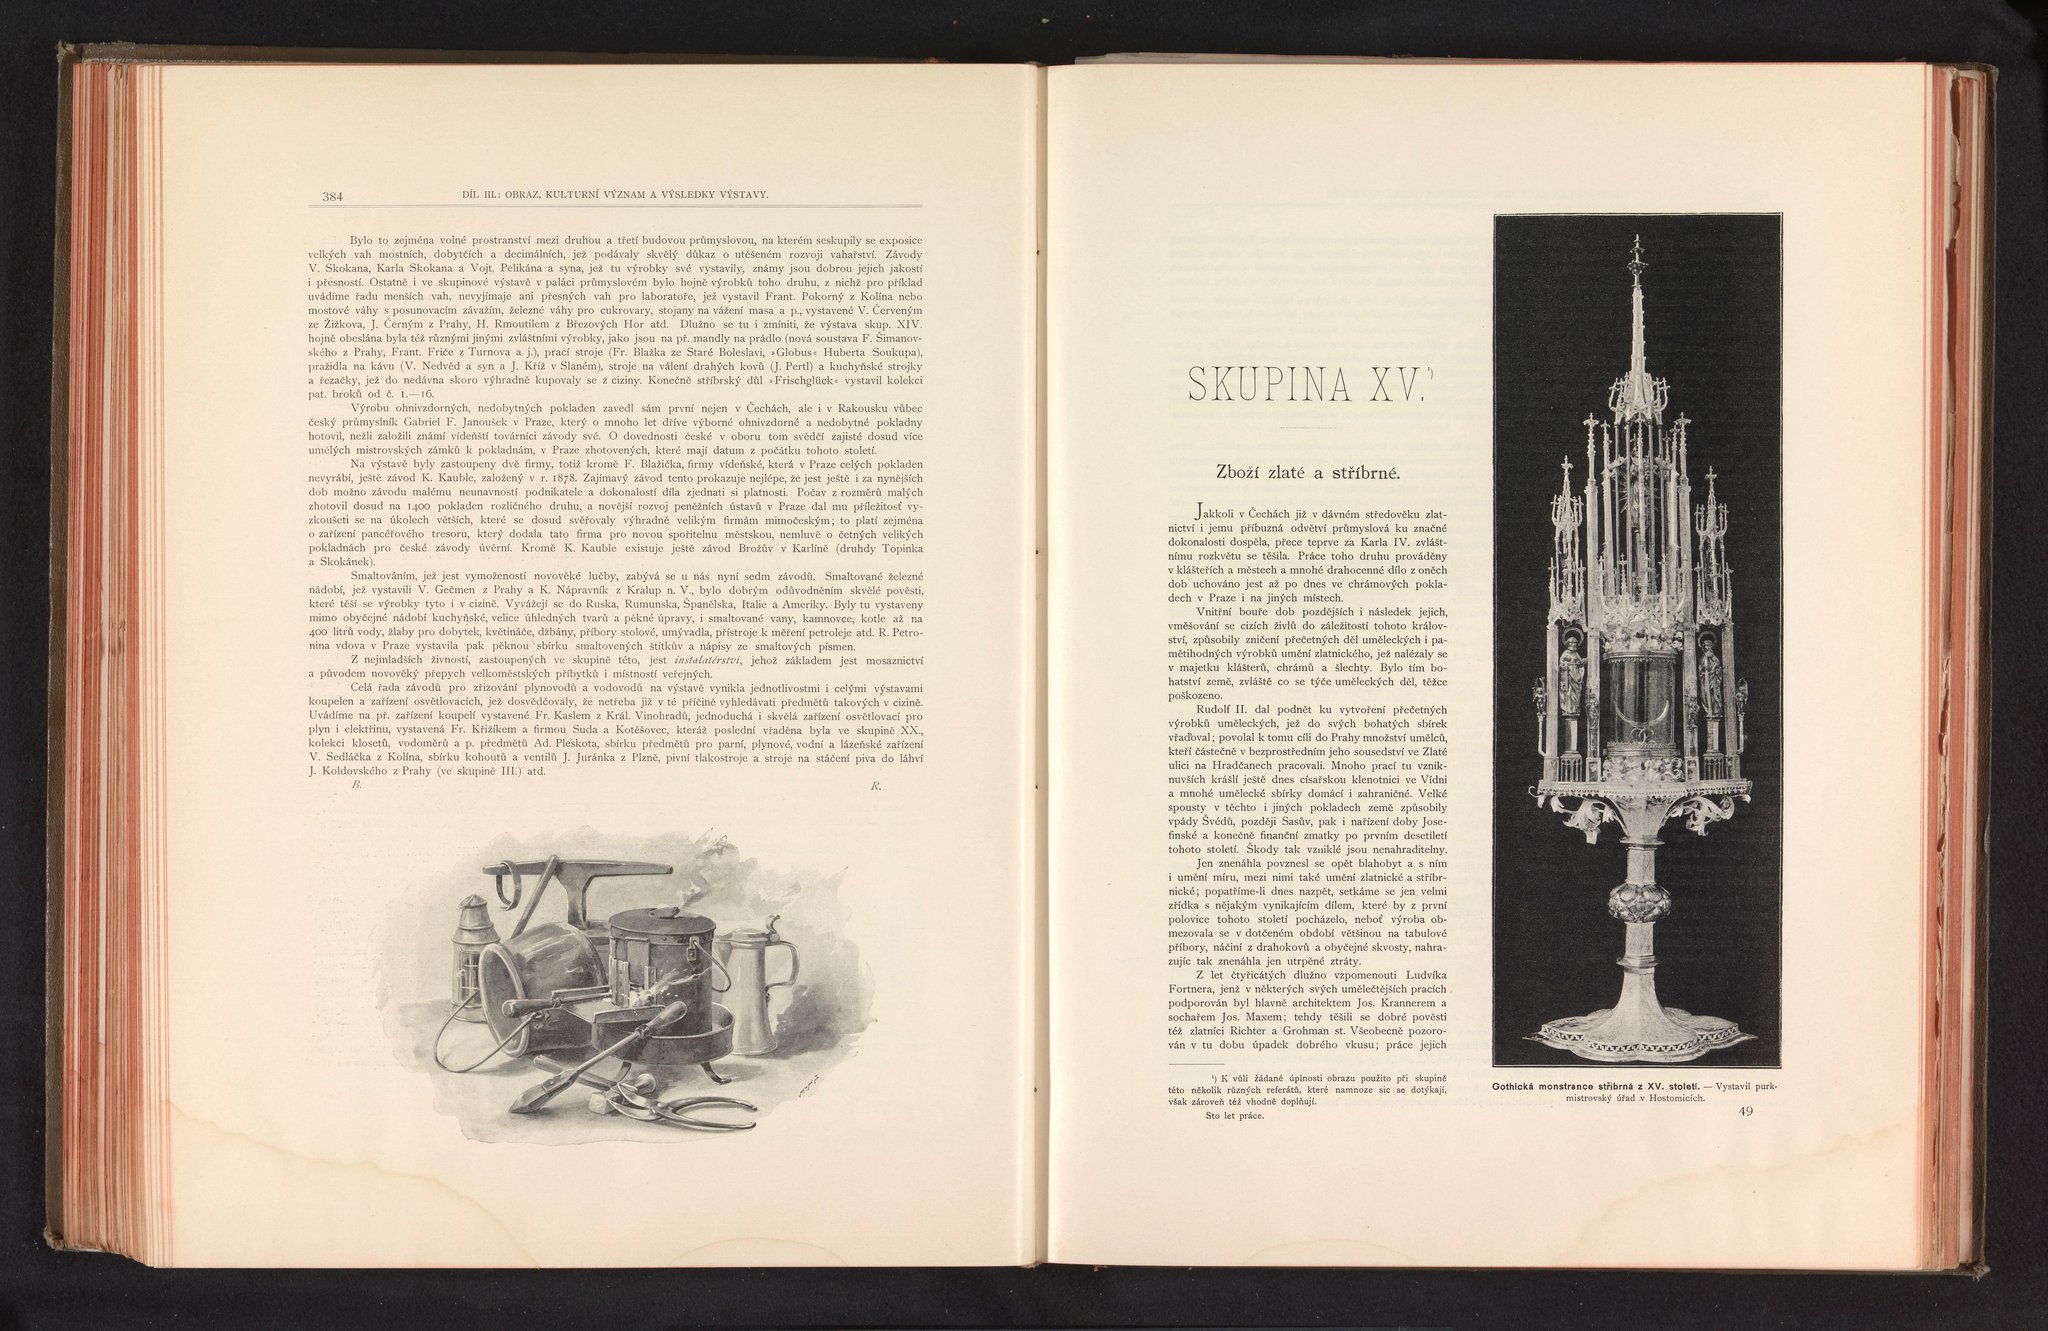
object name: photomechanical print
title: Gothiká monstrance stribrná z XV. stoleti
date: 1890-1895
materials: paper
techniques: autotype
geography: prague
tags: ostensorium, monstrance